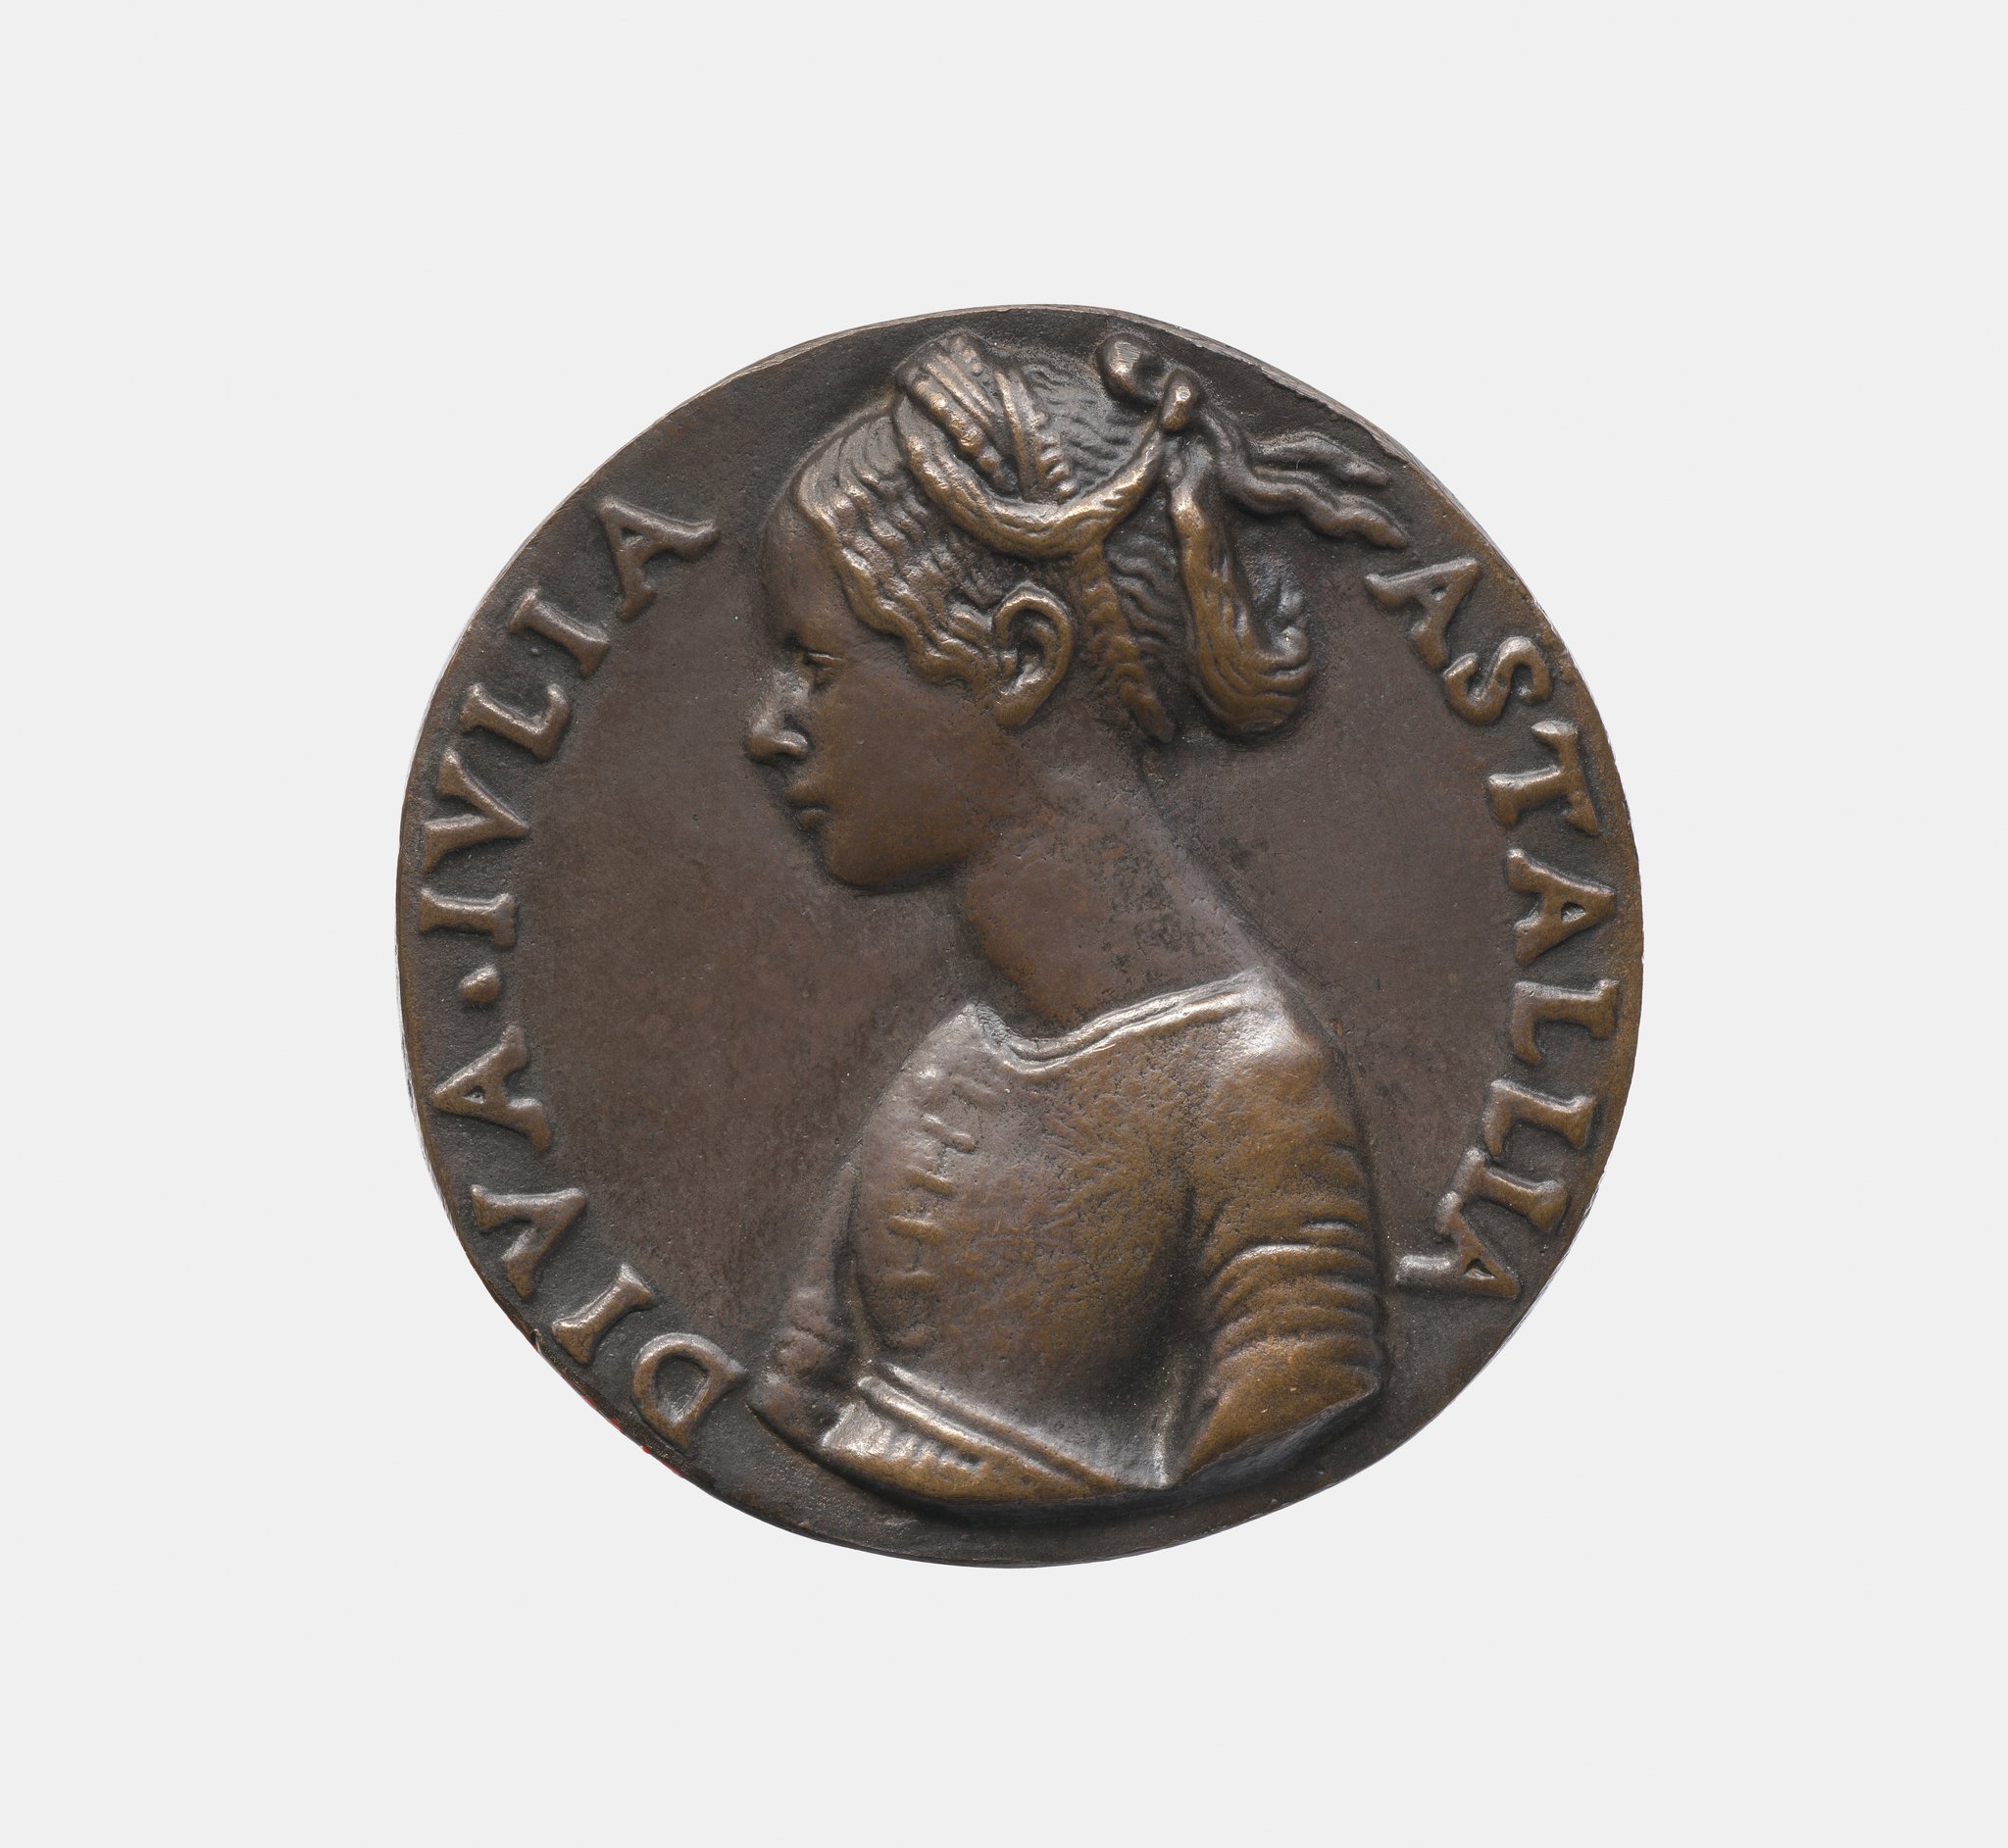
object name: medal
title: Giulia Astallia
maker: Anonymous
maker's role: artist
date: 1485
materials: bronze